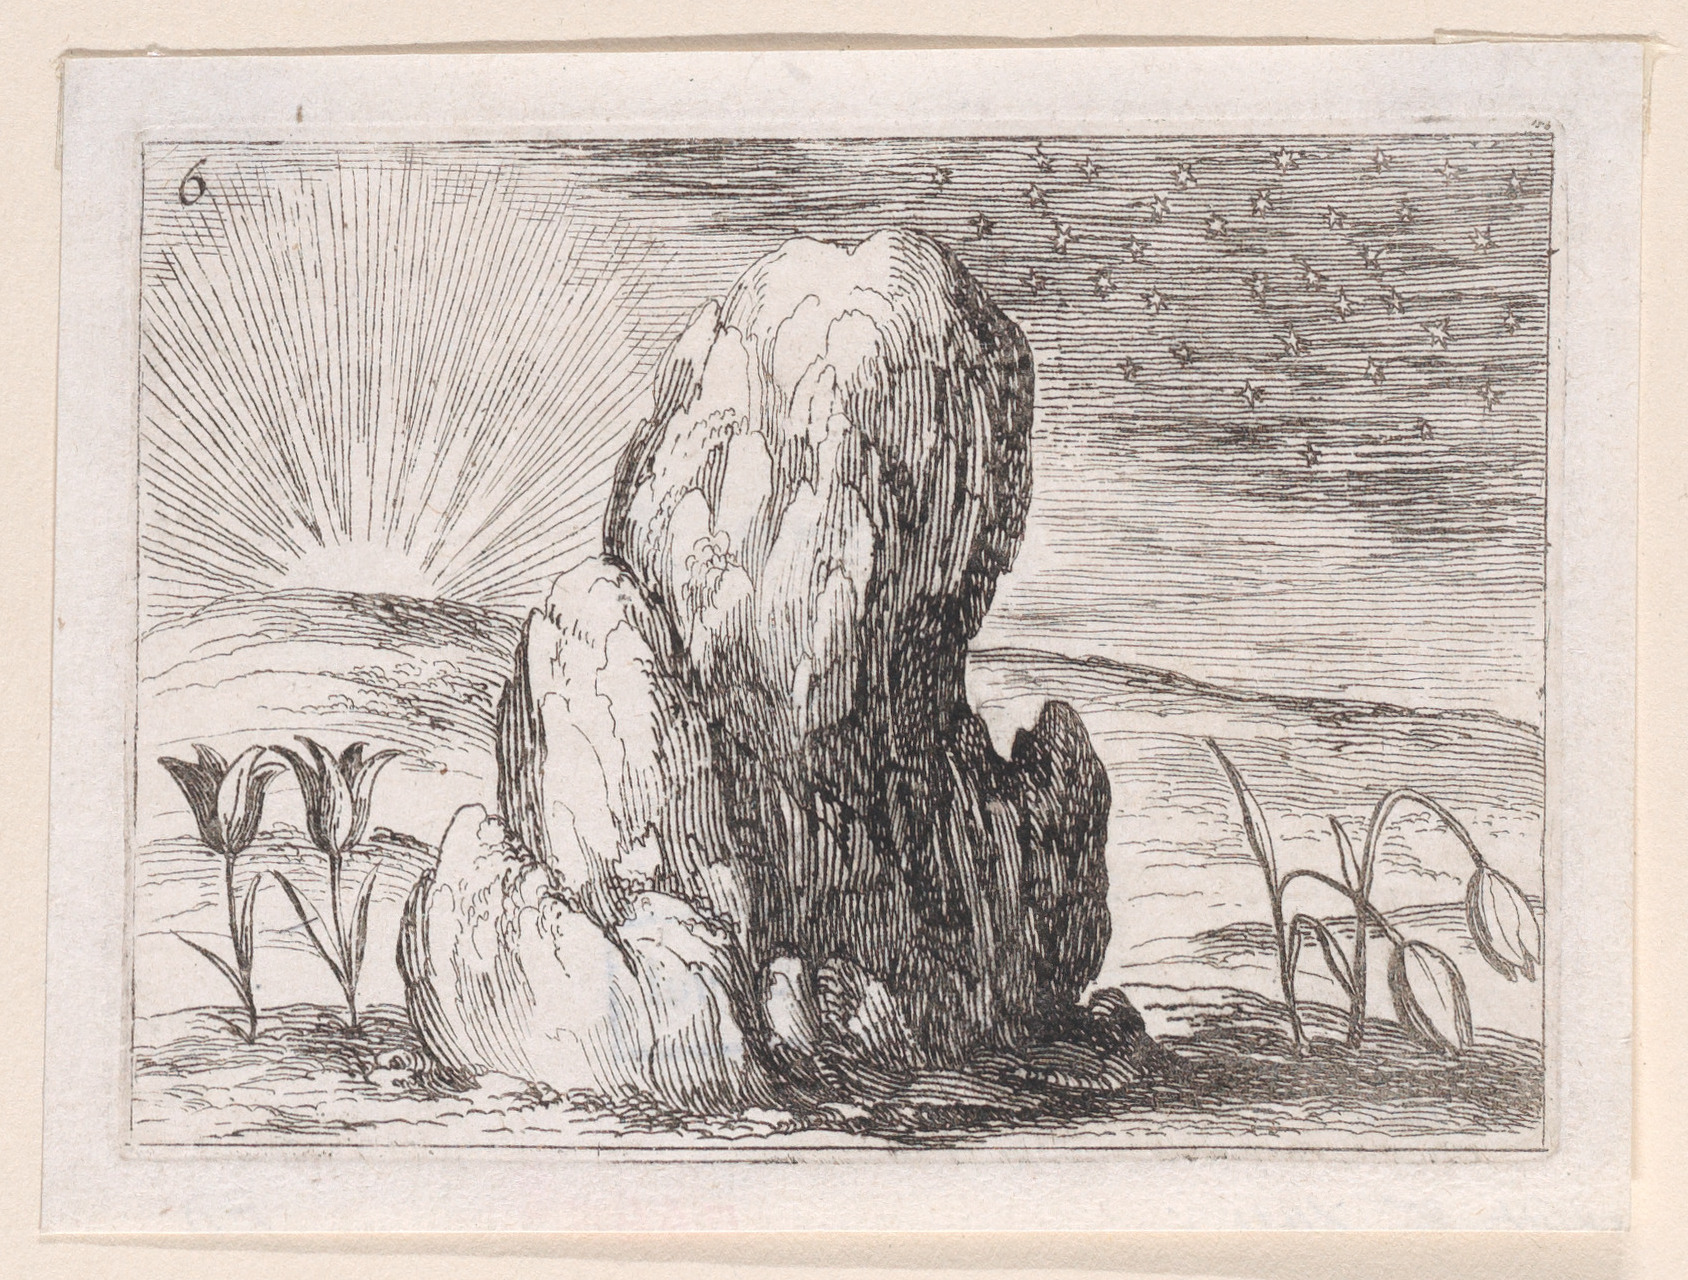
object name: print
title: Les Tulipes et le Soleil (The Tulips and the Sun), plate 6 from "Lux Claustri ou La Lumière du Cloitre" (The Light of the Cloisters)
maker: jacques callot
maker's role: artist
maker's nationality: french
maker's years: 1592-1635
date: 1621-1635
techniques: etching